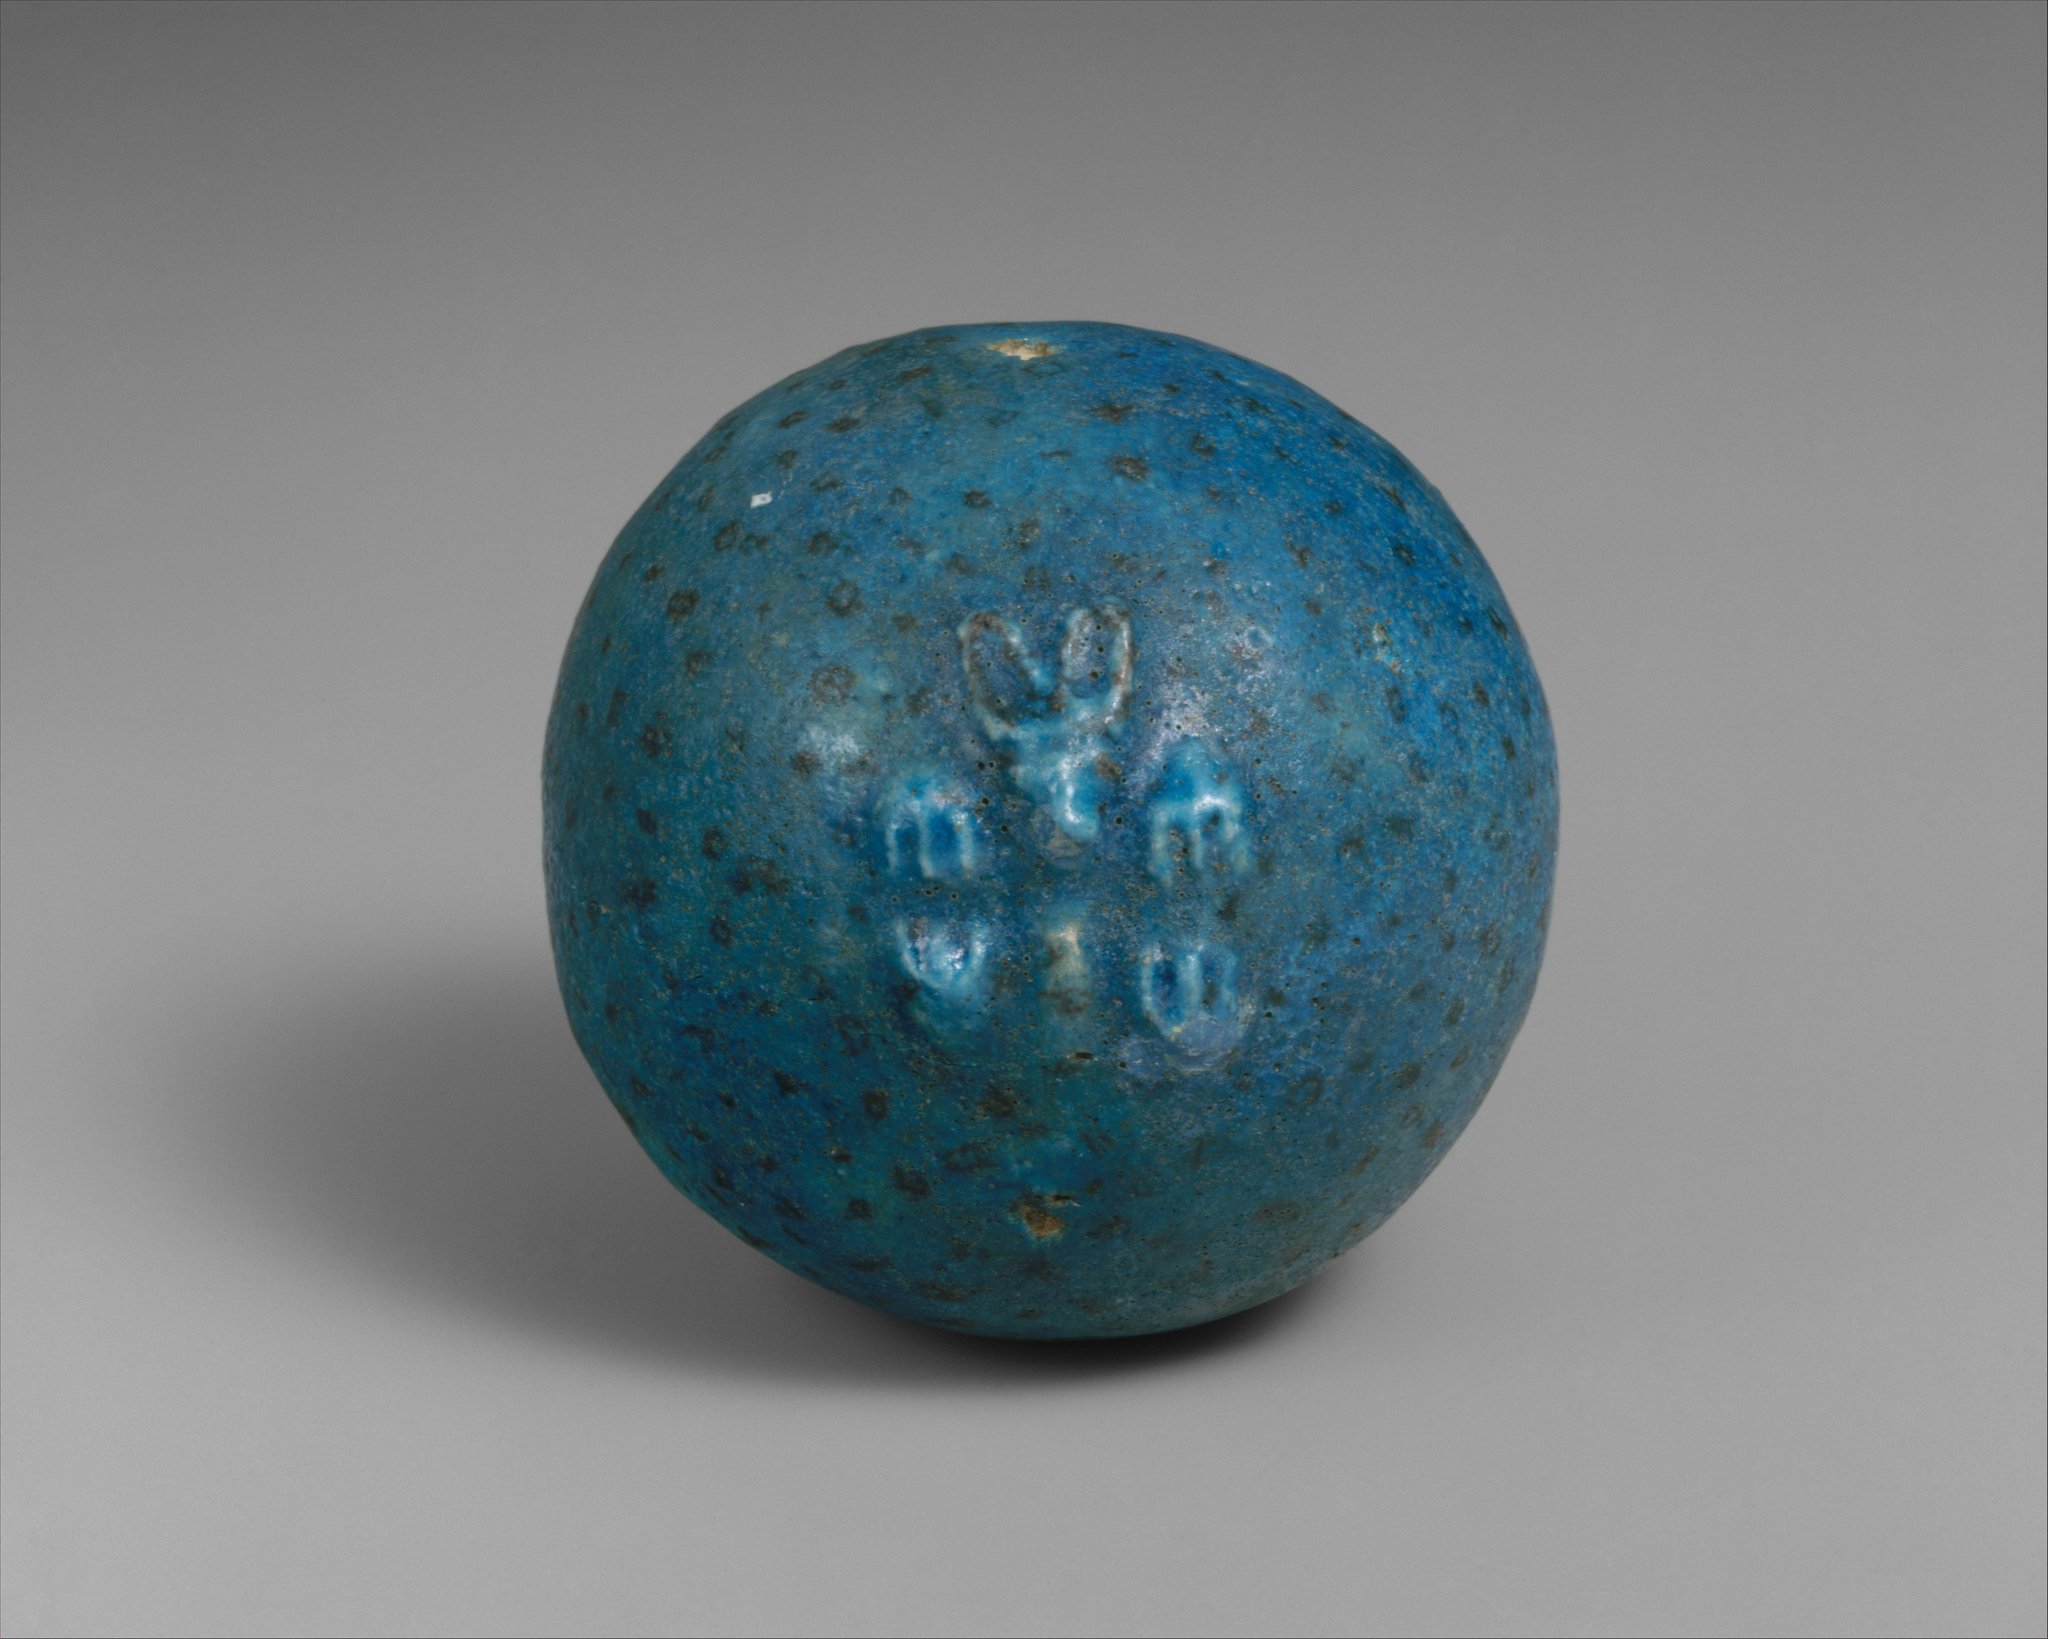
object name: amulet, hedgehog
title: Hedgehog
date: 1550-1450 BCE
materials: faience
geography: egypt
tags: animals